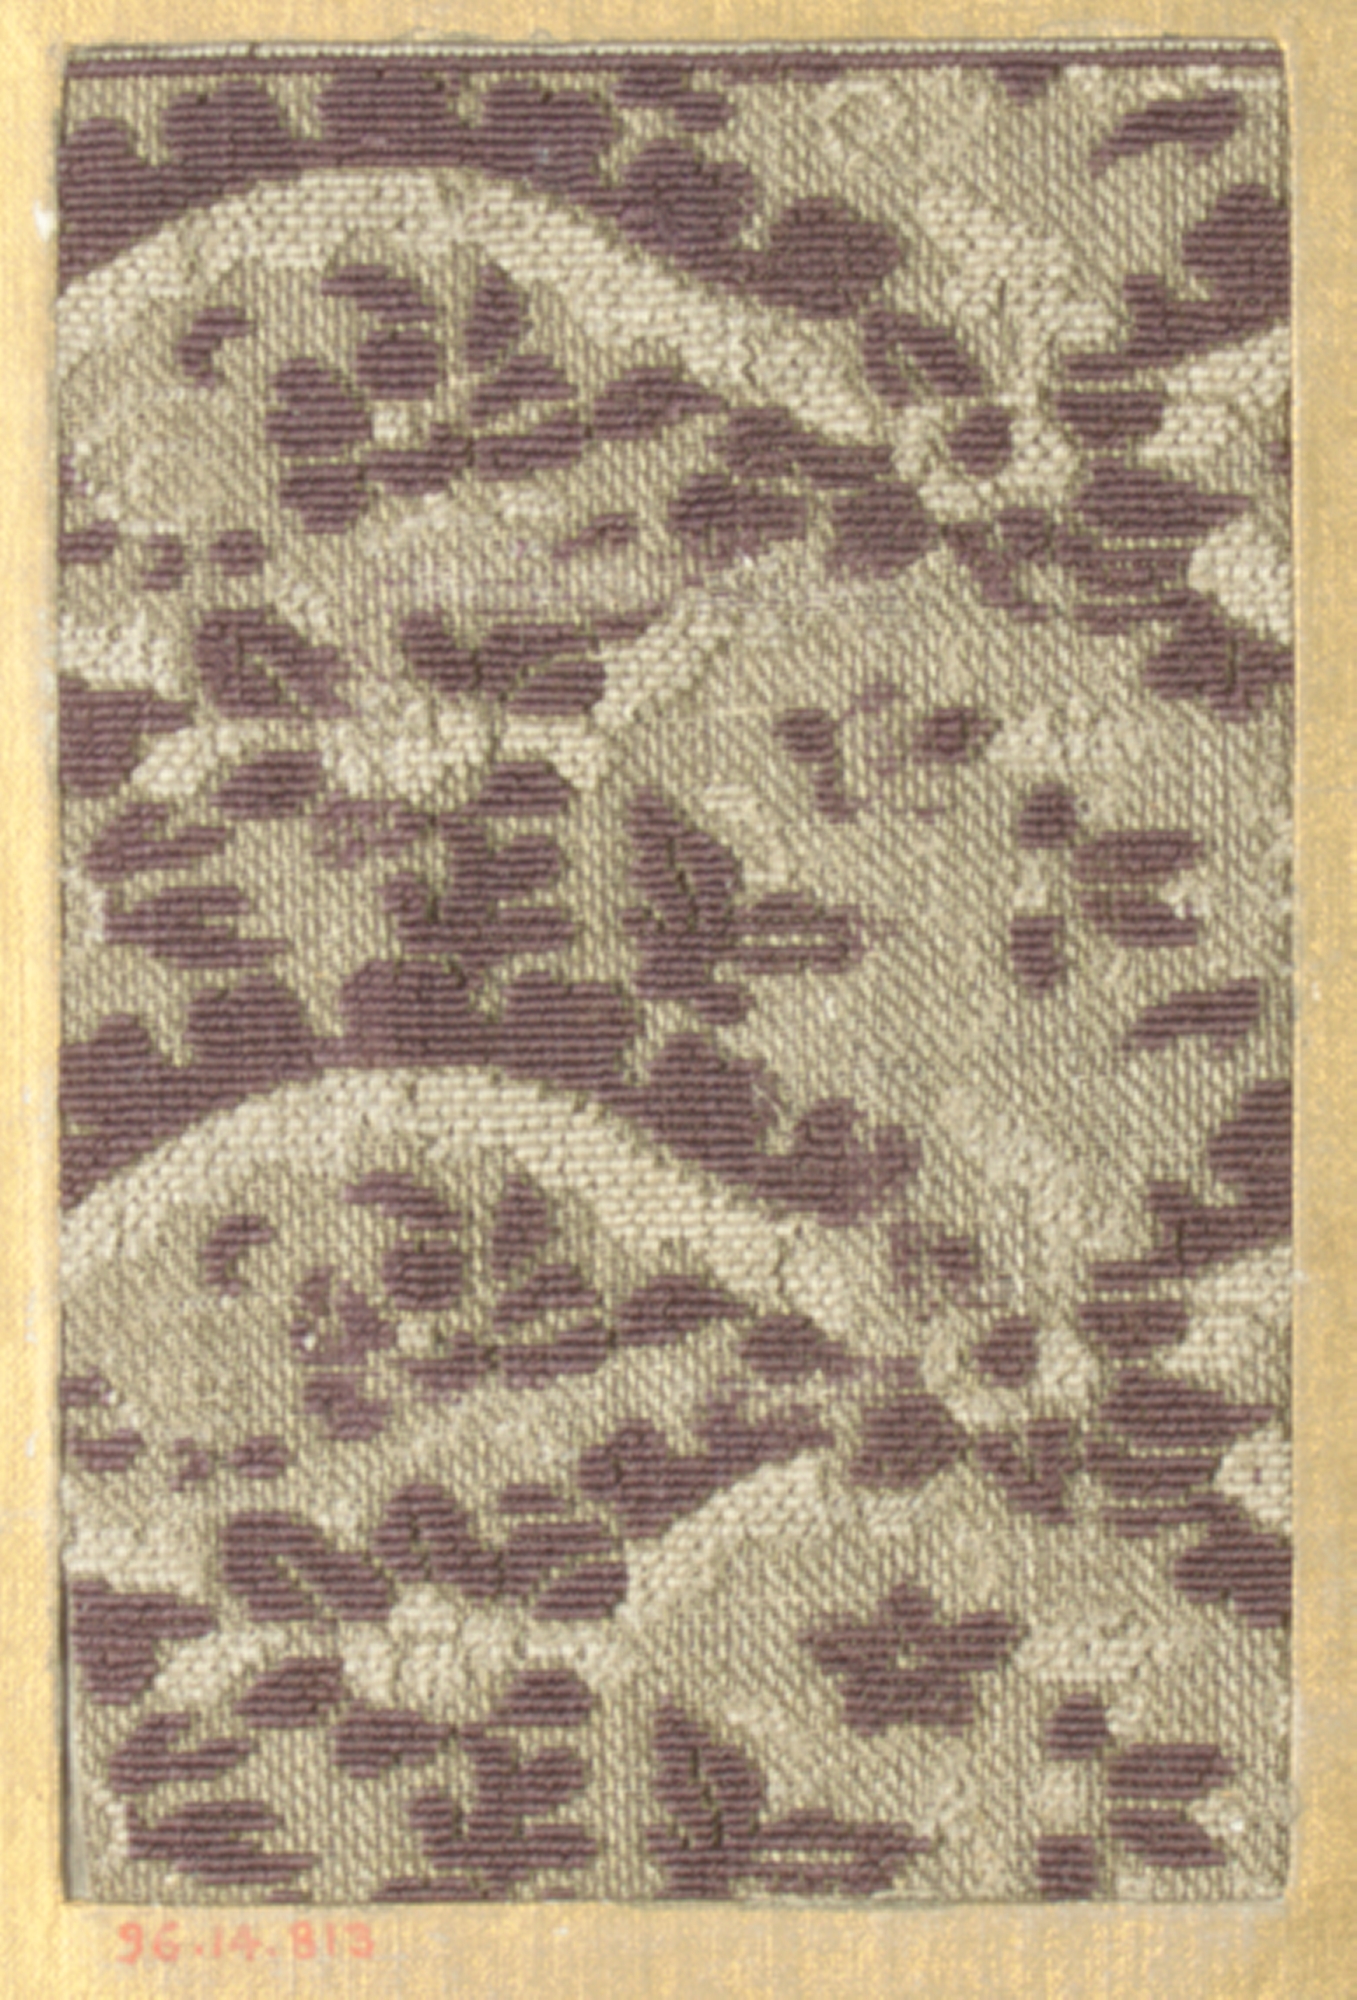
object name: piece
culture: japanese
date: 1701-1900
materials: silk